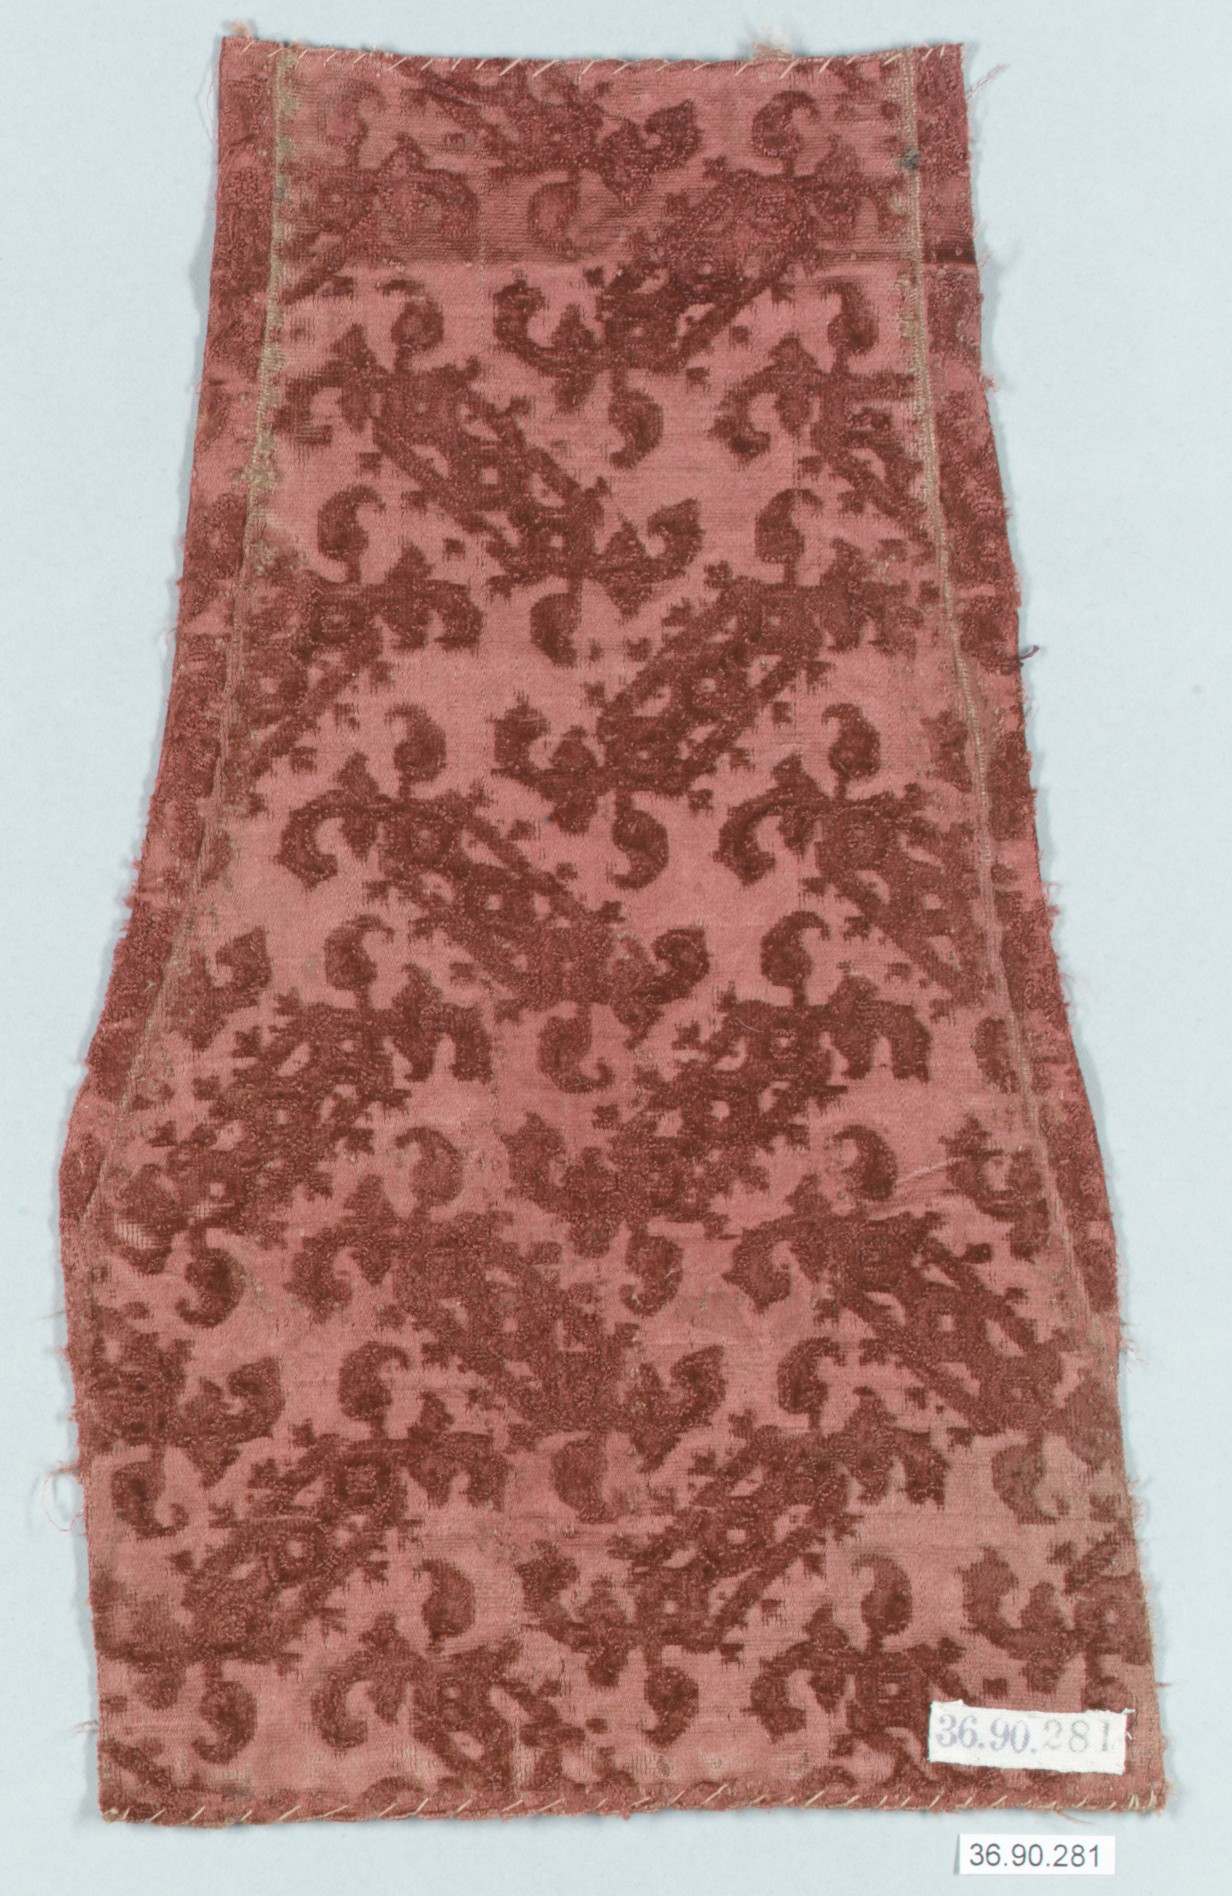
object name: piece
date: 1501-1700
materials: silk